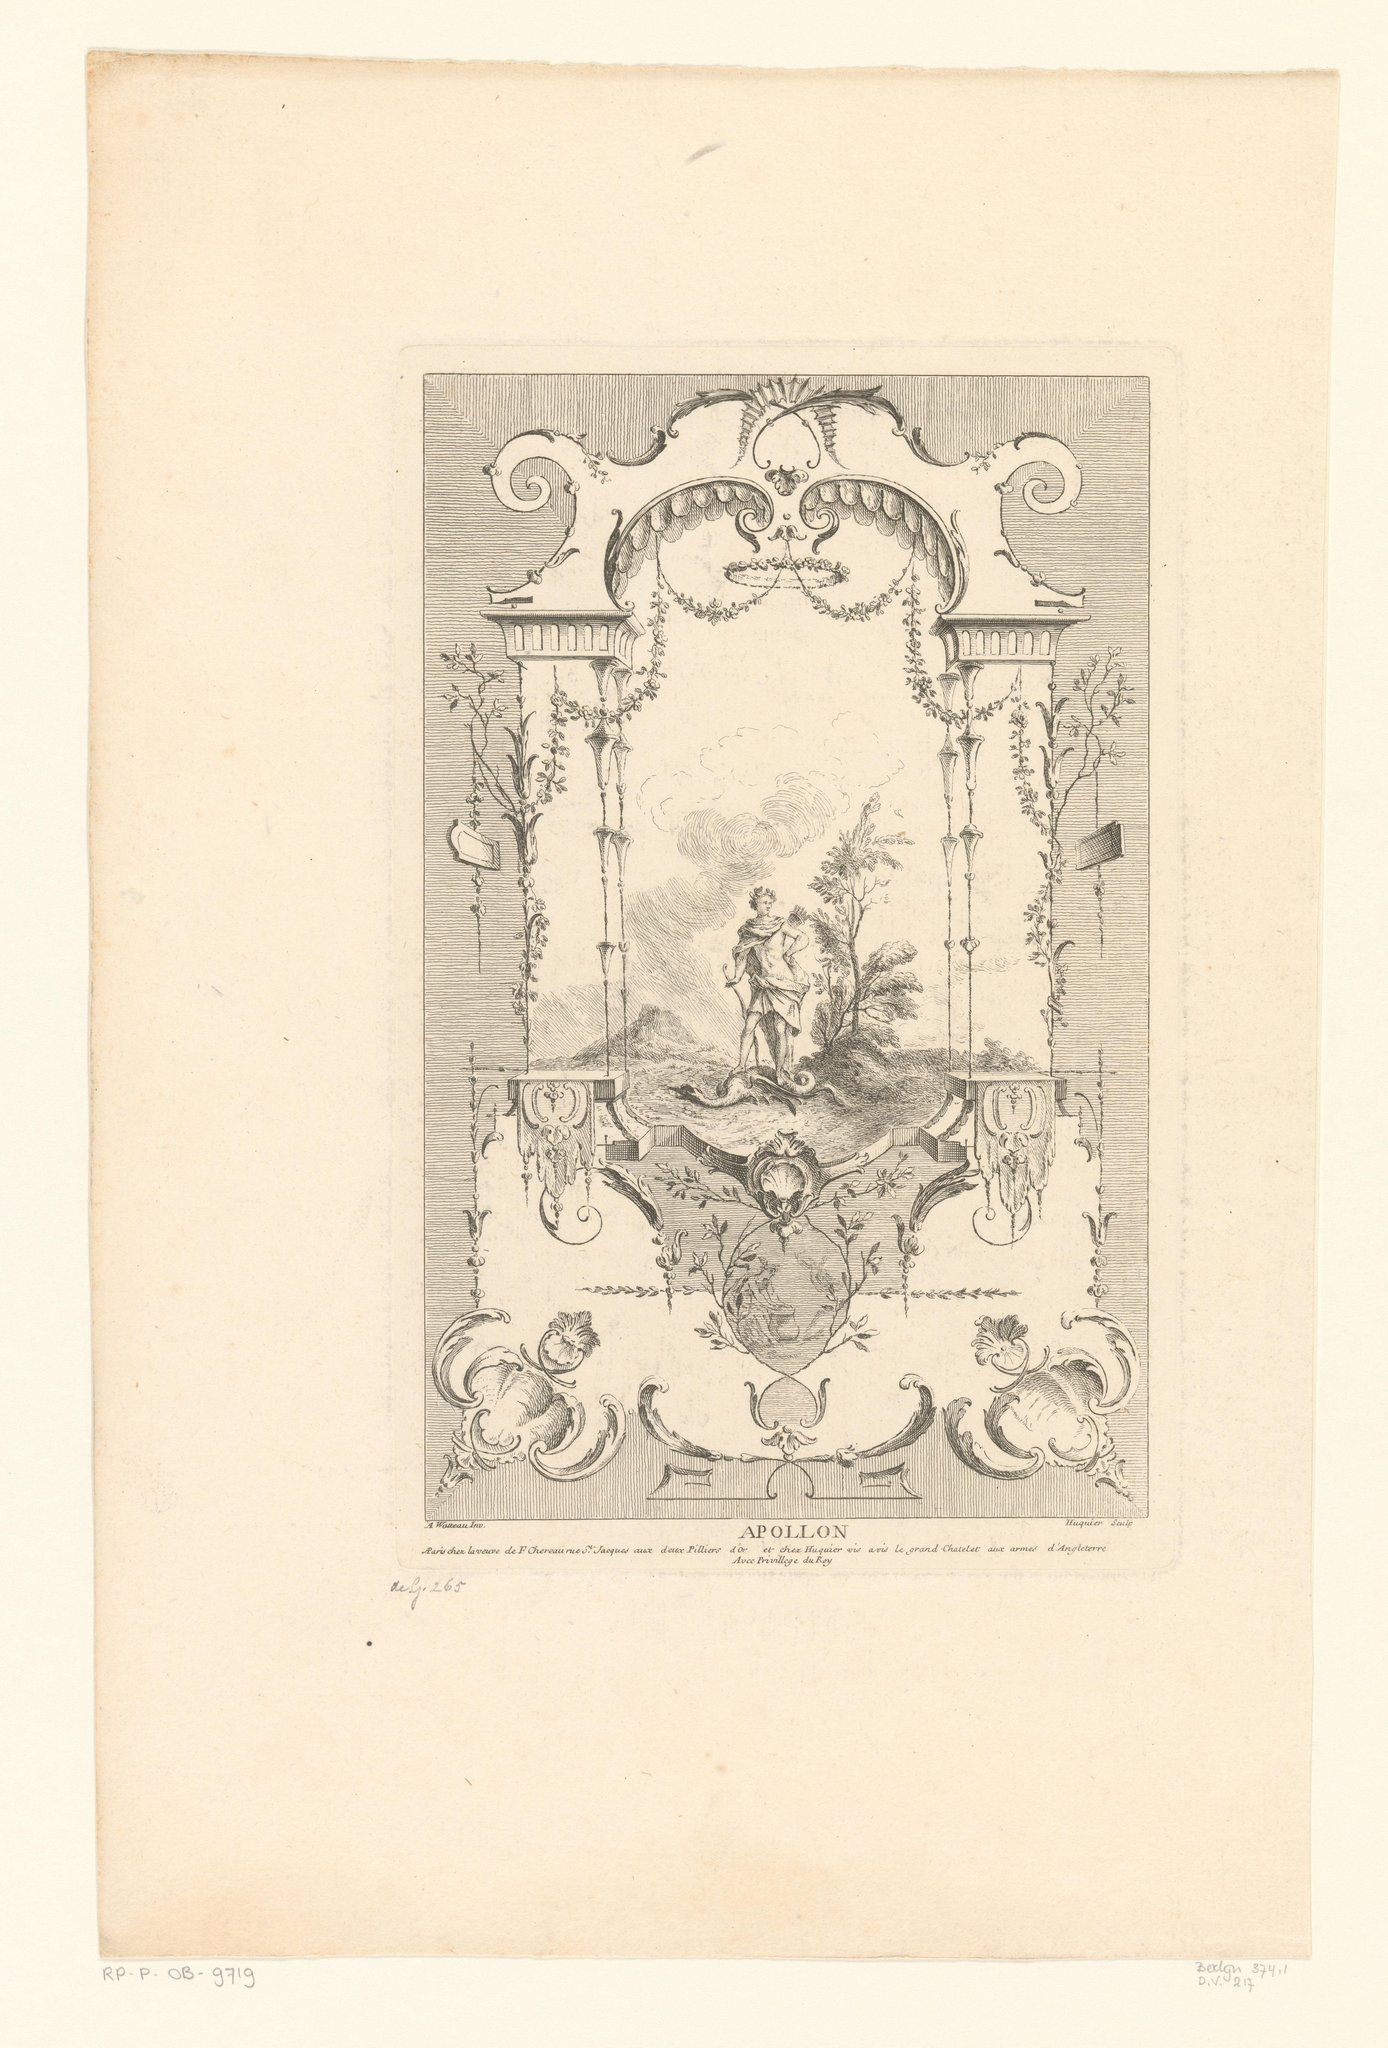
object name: print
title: Apollon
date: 1729-1737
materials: paper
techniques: etching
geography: paris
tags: (story of) apollo (phoebus)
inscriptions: collector's mark: Lugt 2228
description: In een landschap staat Apollo met pijlenkoker en boog met de verslagen draak Python aan zijn voeten. Rondom de voorstelling een omlijsting met guirlandes, bladmotieven en rocailles.